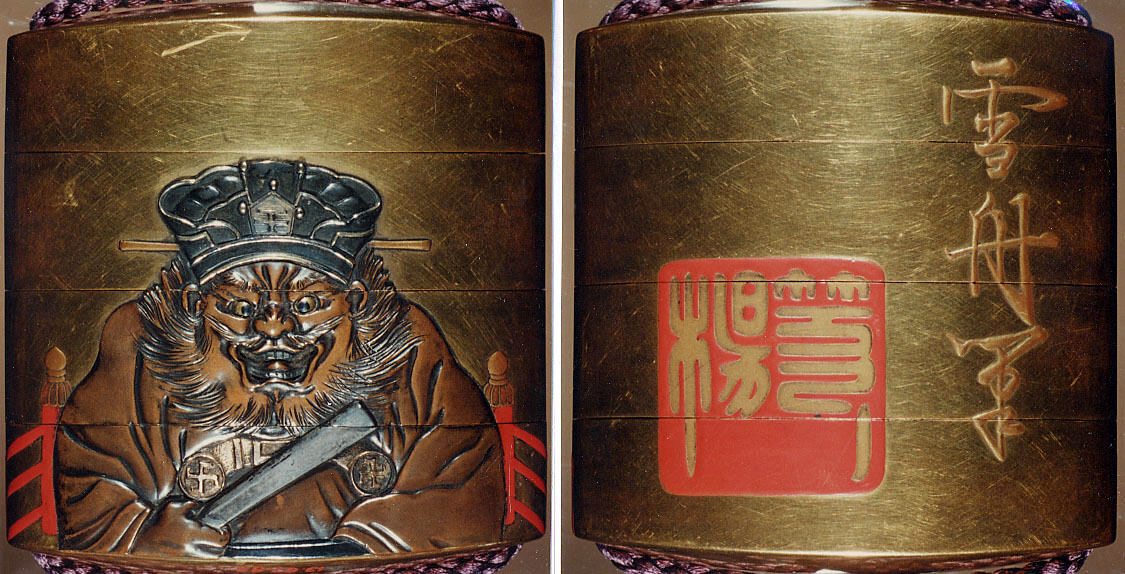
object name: inrō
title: Case (Inrō) with Design of Emmao (King of Hell) Seated on Chair (obverse); Seal and Inscription (reverse)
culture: japanese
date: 1801-1900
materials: gold, lacquer, metal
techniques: fundame, hiramakie, inlay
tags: men